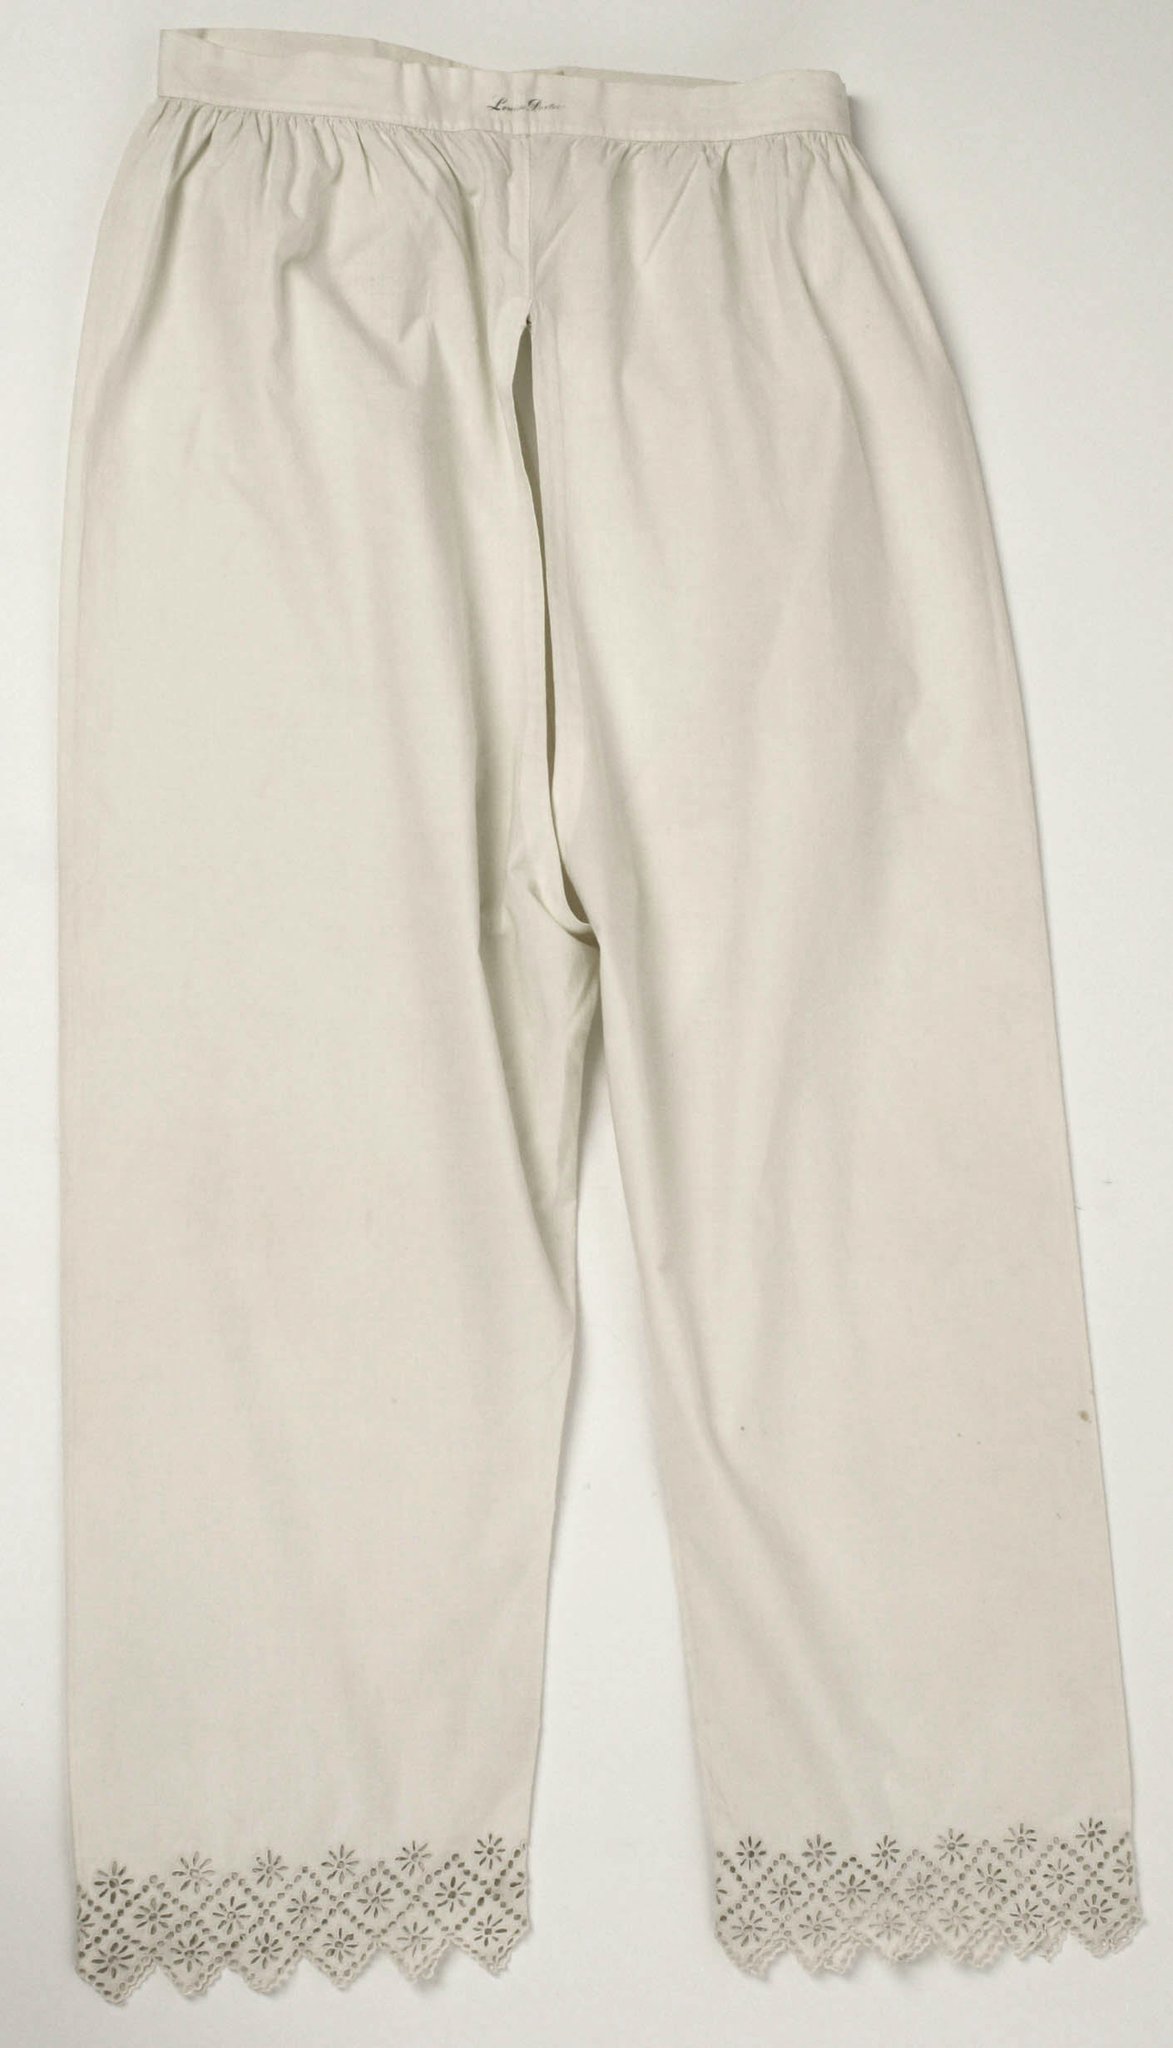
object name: pantalets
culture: american or european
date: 1802-1820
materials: cotton